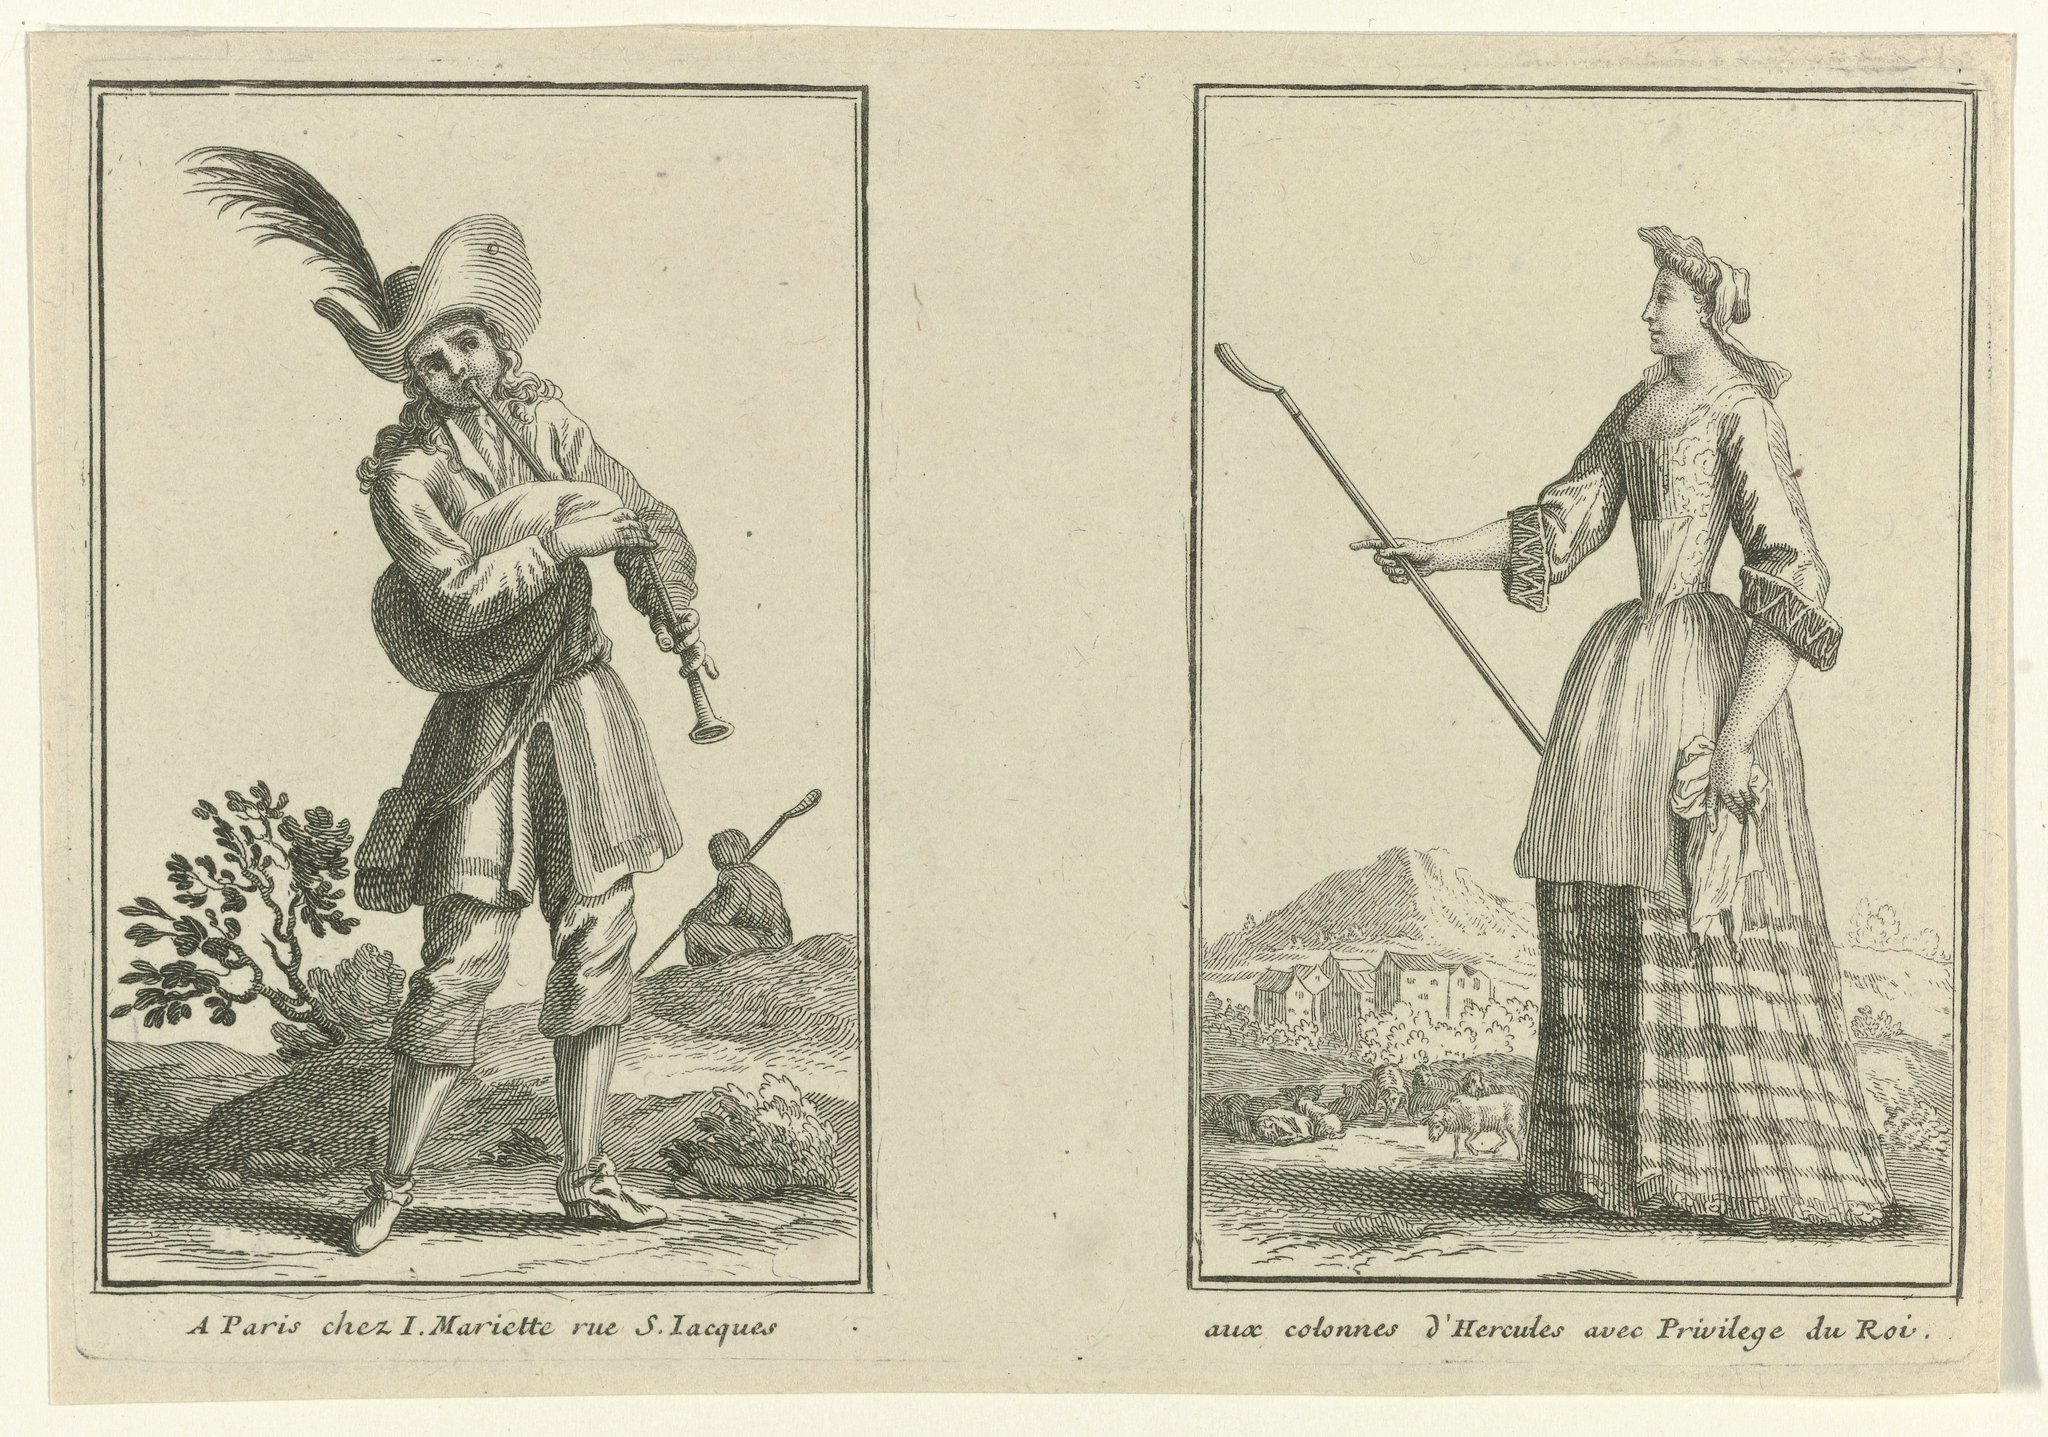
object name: costume print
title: Doedelzakspeler en herderin in landelijke kleding ca. 1695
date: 1695-1700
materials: paper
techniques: etching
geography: paris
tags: herding, herdsman, herdswoman, shepherd, shepherdess, cowherd, etc., head-gear: hat (+ men's clothes), clothes, costume (+ women's clothes), clothes, costume (+ men's clothes), bagpipe, musette - cc - out of doors, head-gear: hat (+ feathers used for clothes)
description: Links een doedelzakspeler met hoed met pluim; rechts een herderin met herdersstaf, in landelijke kleding ca. 1695.